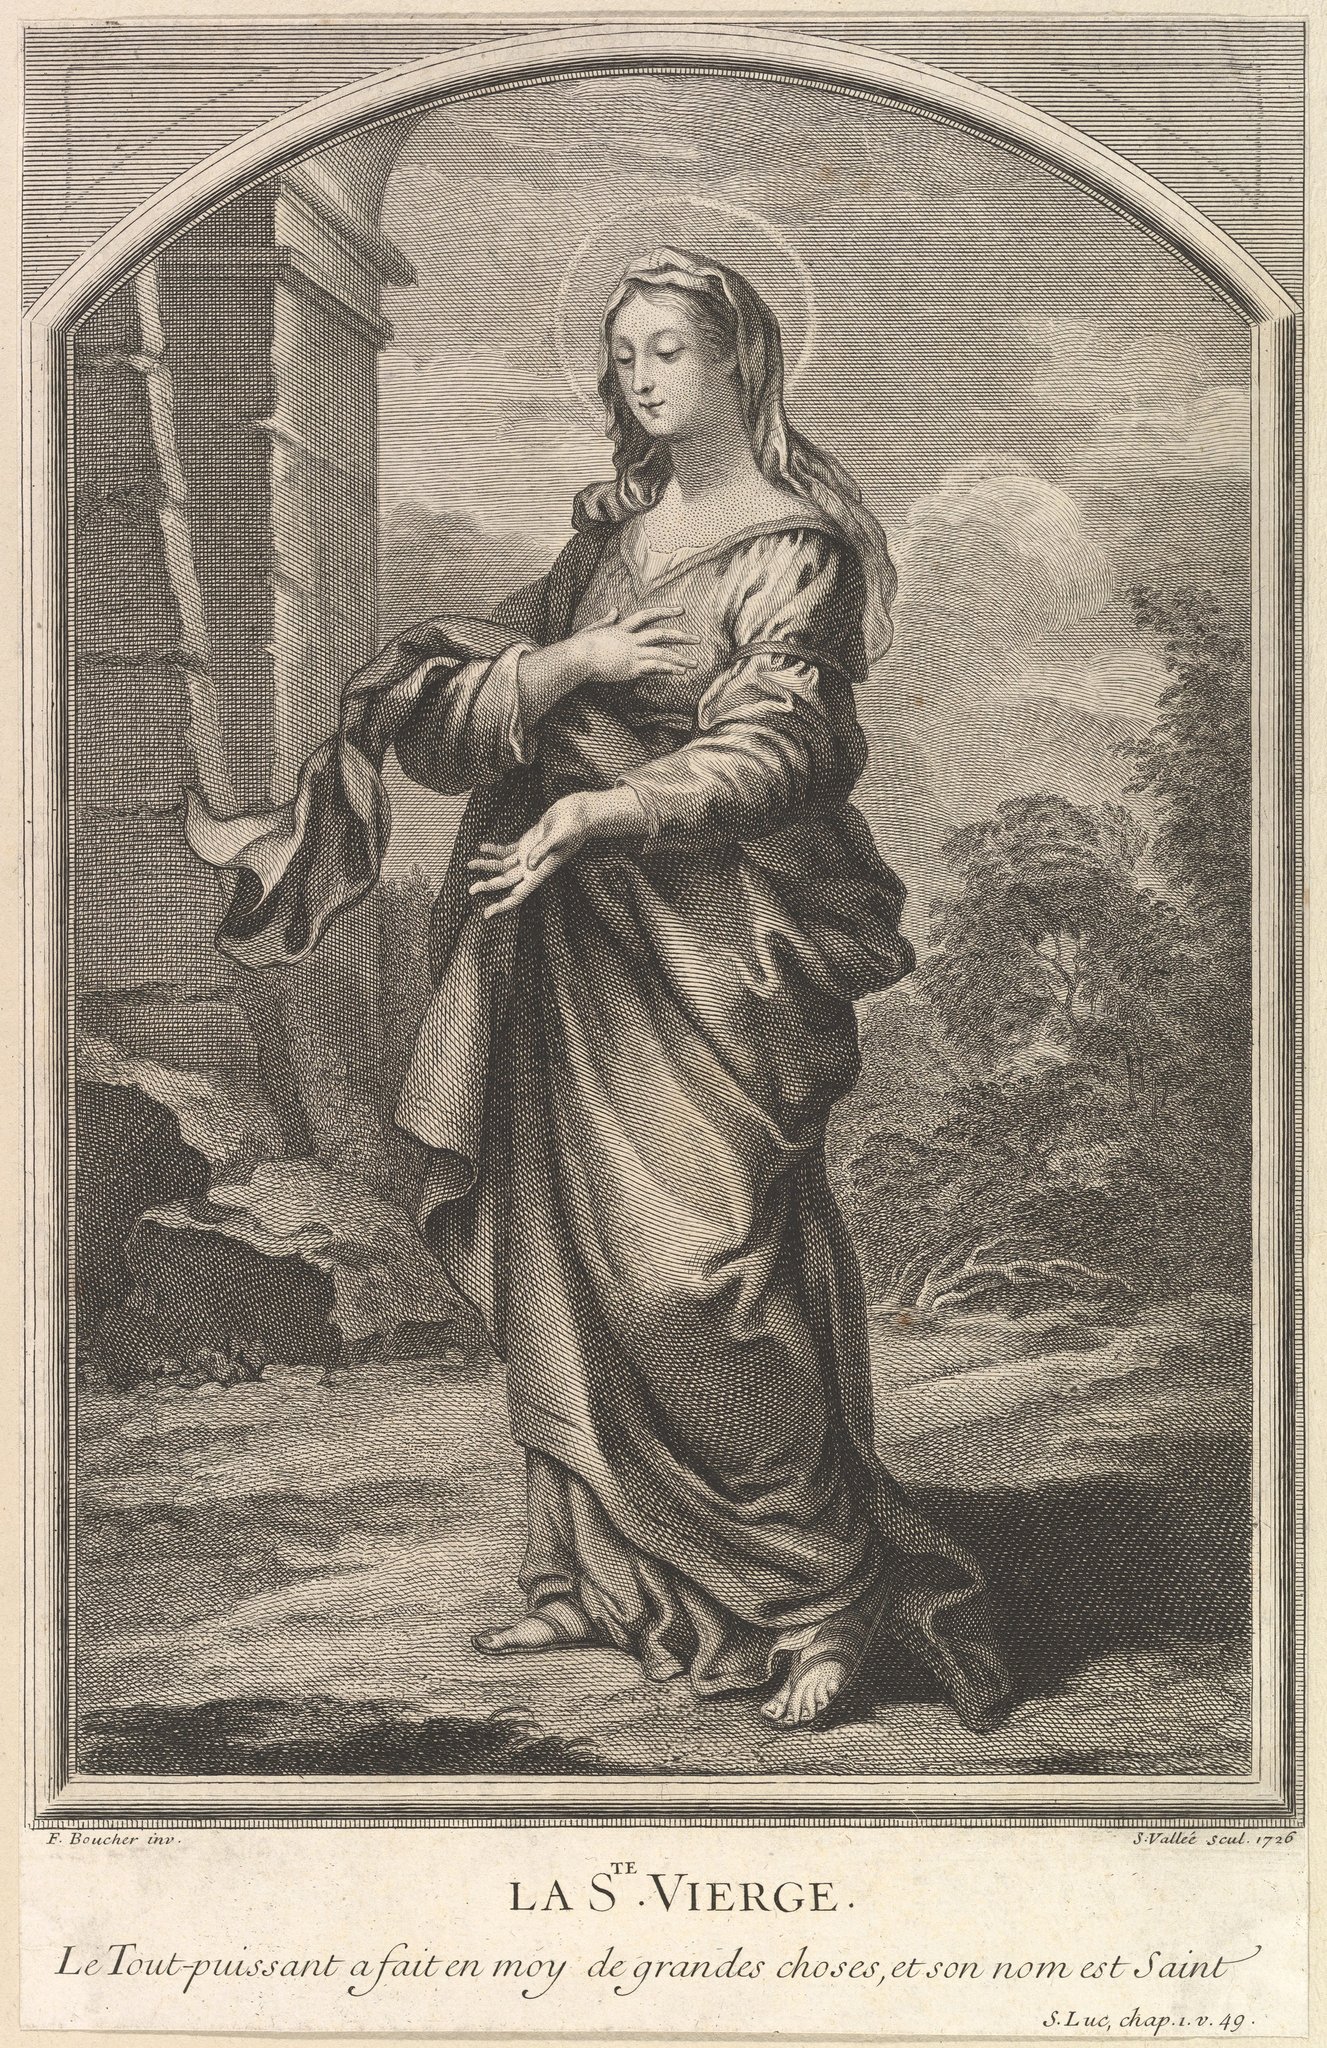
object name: print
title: The Blessed Virgin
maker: simon de la vallée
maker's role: artist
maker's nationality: french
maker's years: 1700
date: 1726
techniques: engraving, etching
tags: virgin mary